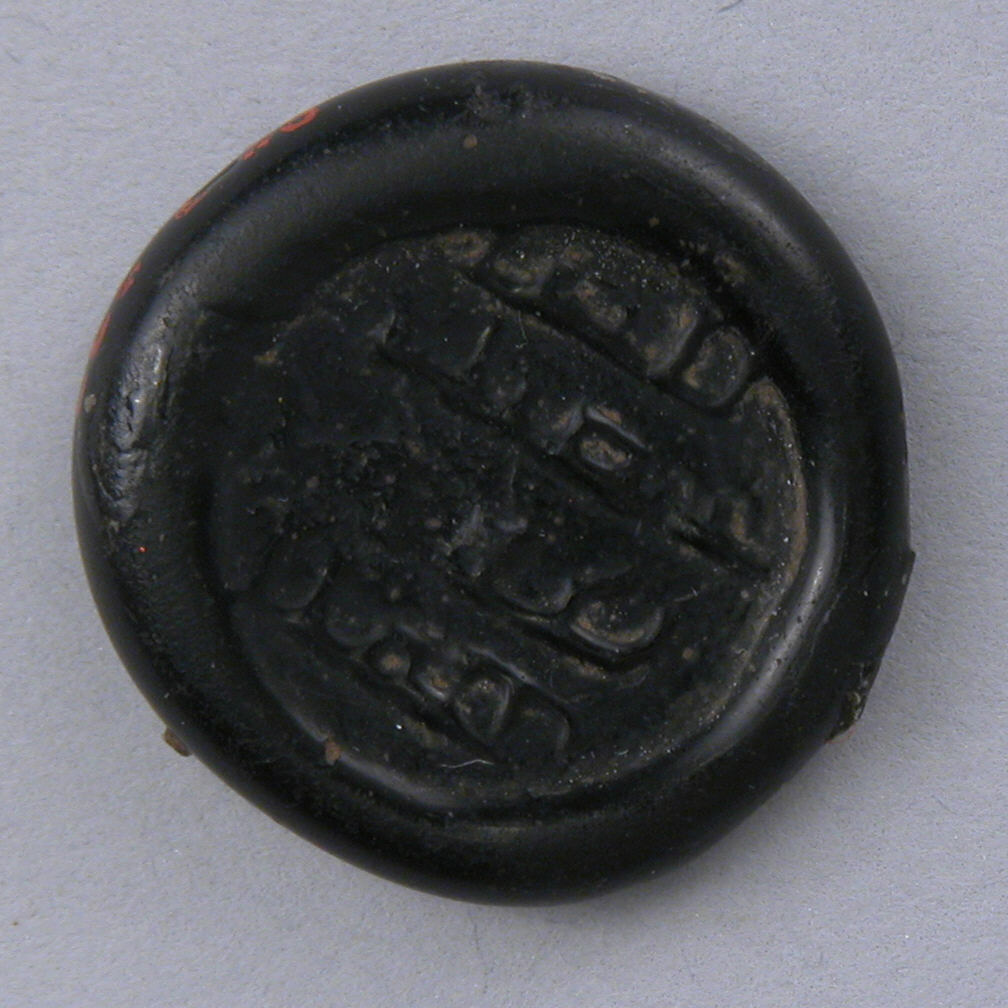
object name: coin weight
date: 1201-1400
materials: glass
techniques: stamping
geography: egypt